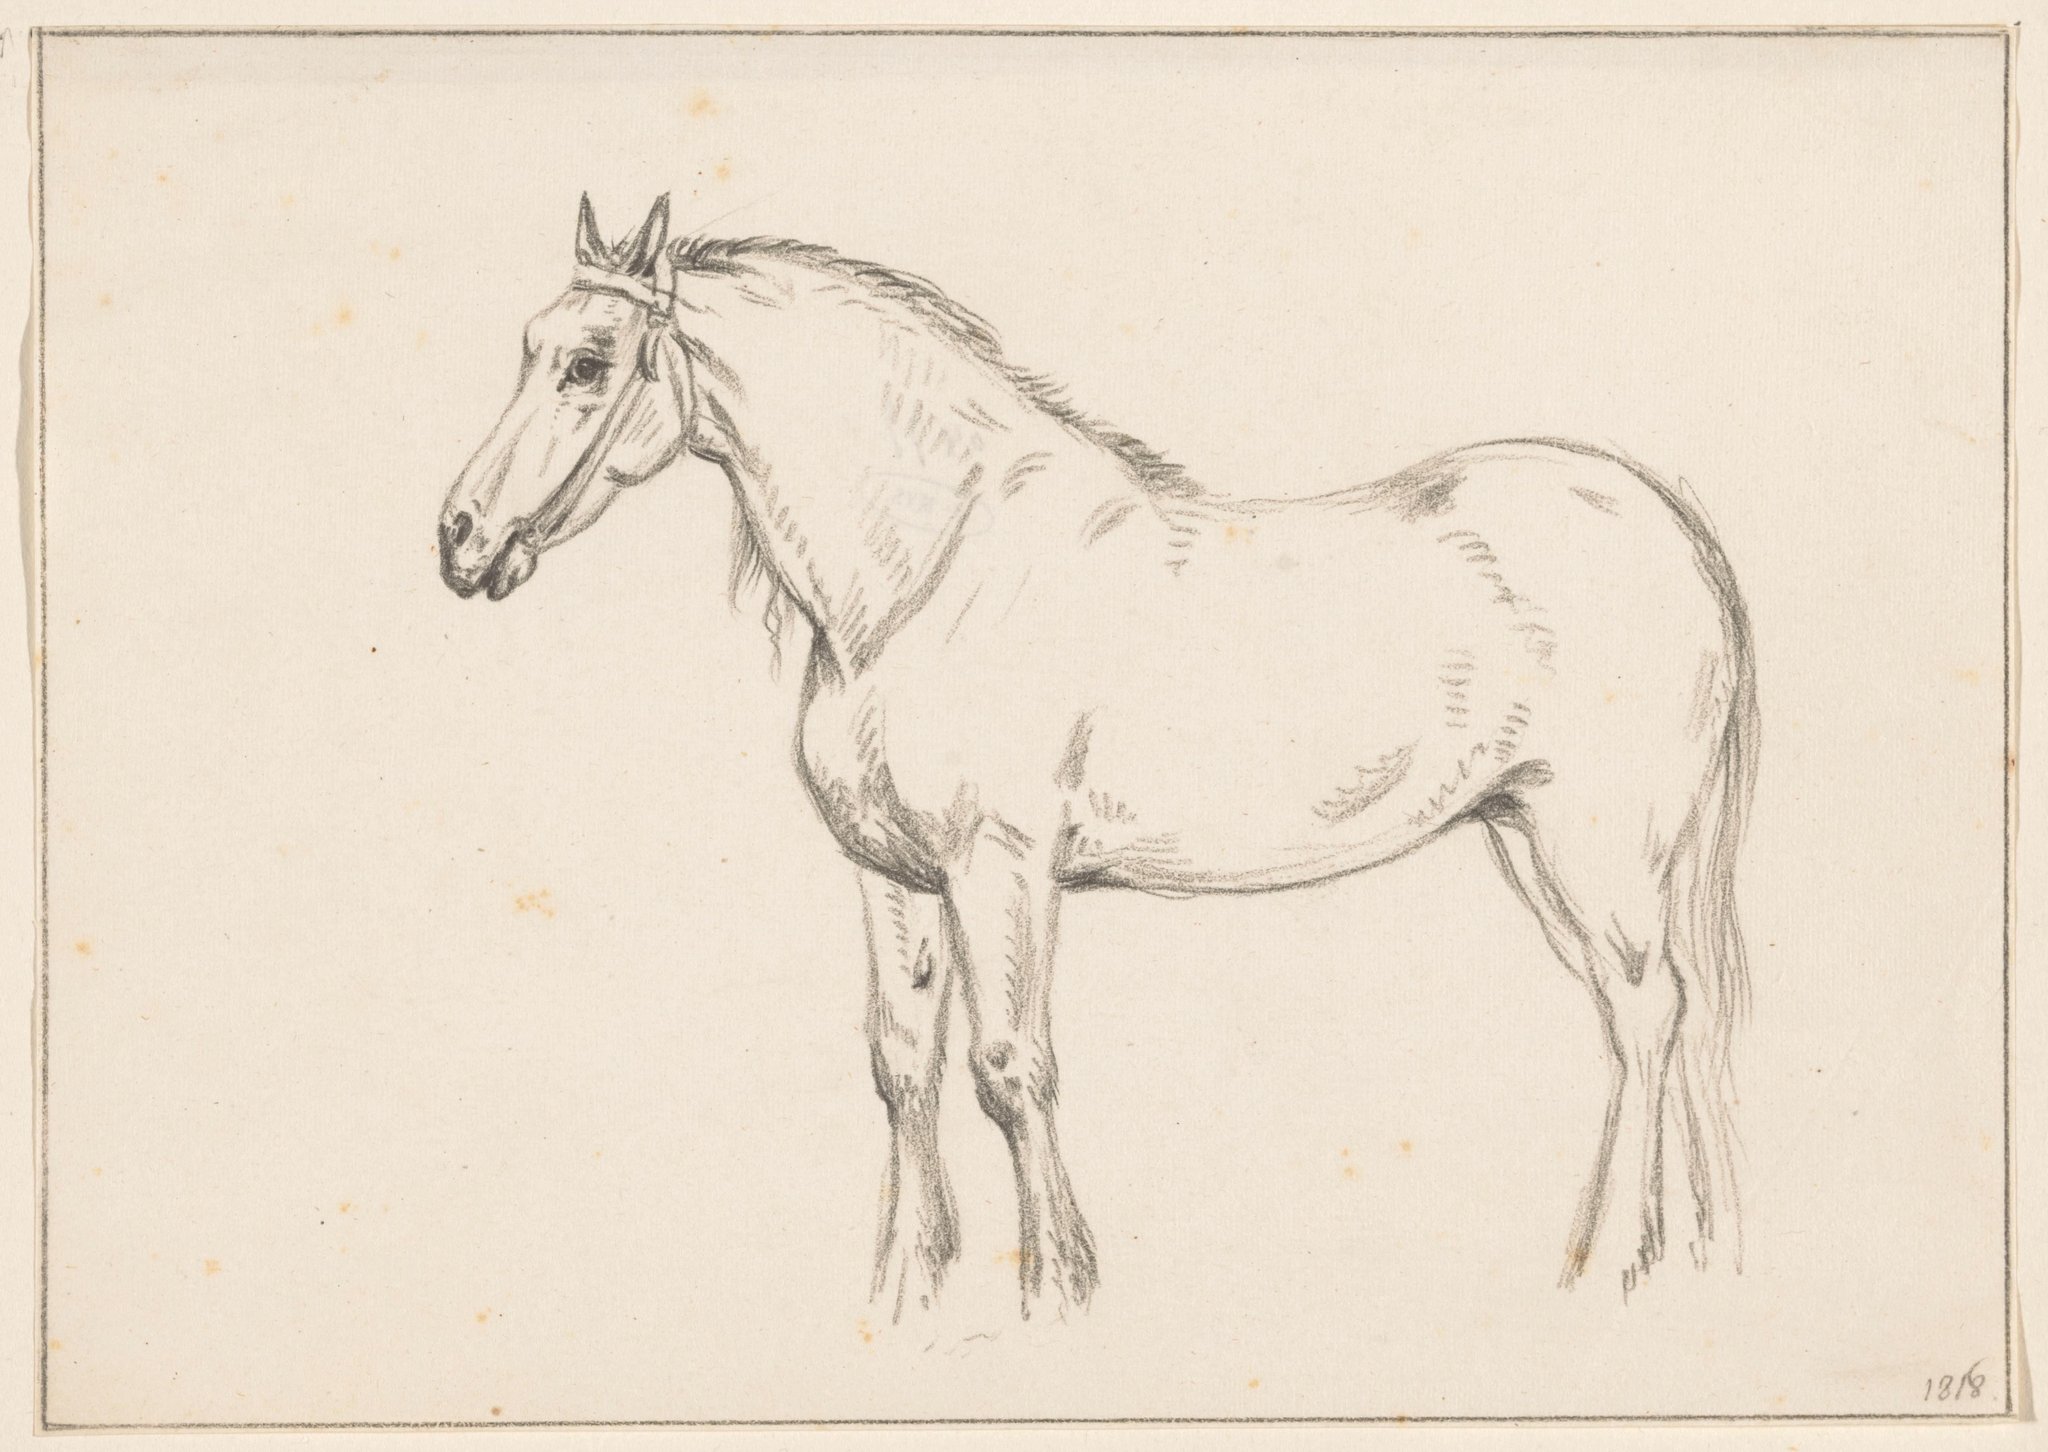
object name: drawing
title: Staand paard, naar links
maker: jean bernard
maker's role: draughtsman, print maker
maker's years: 1765-1833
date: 1818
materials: chalk, paper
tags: horse